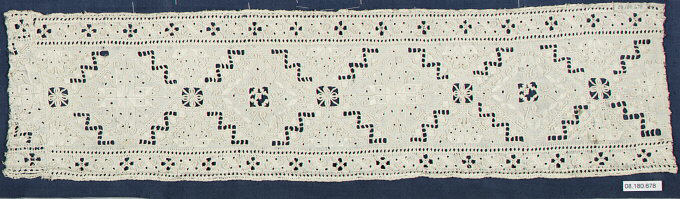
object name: band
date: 1501-1600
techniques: embroidery